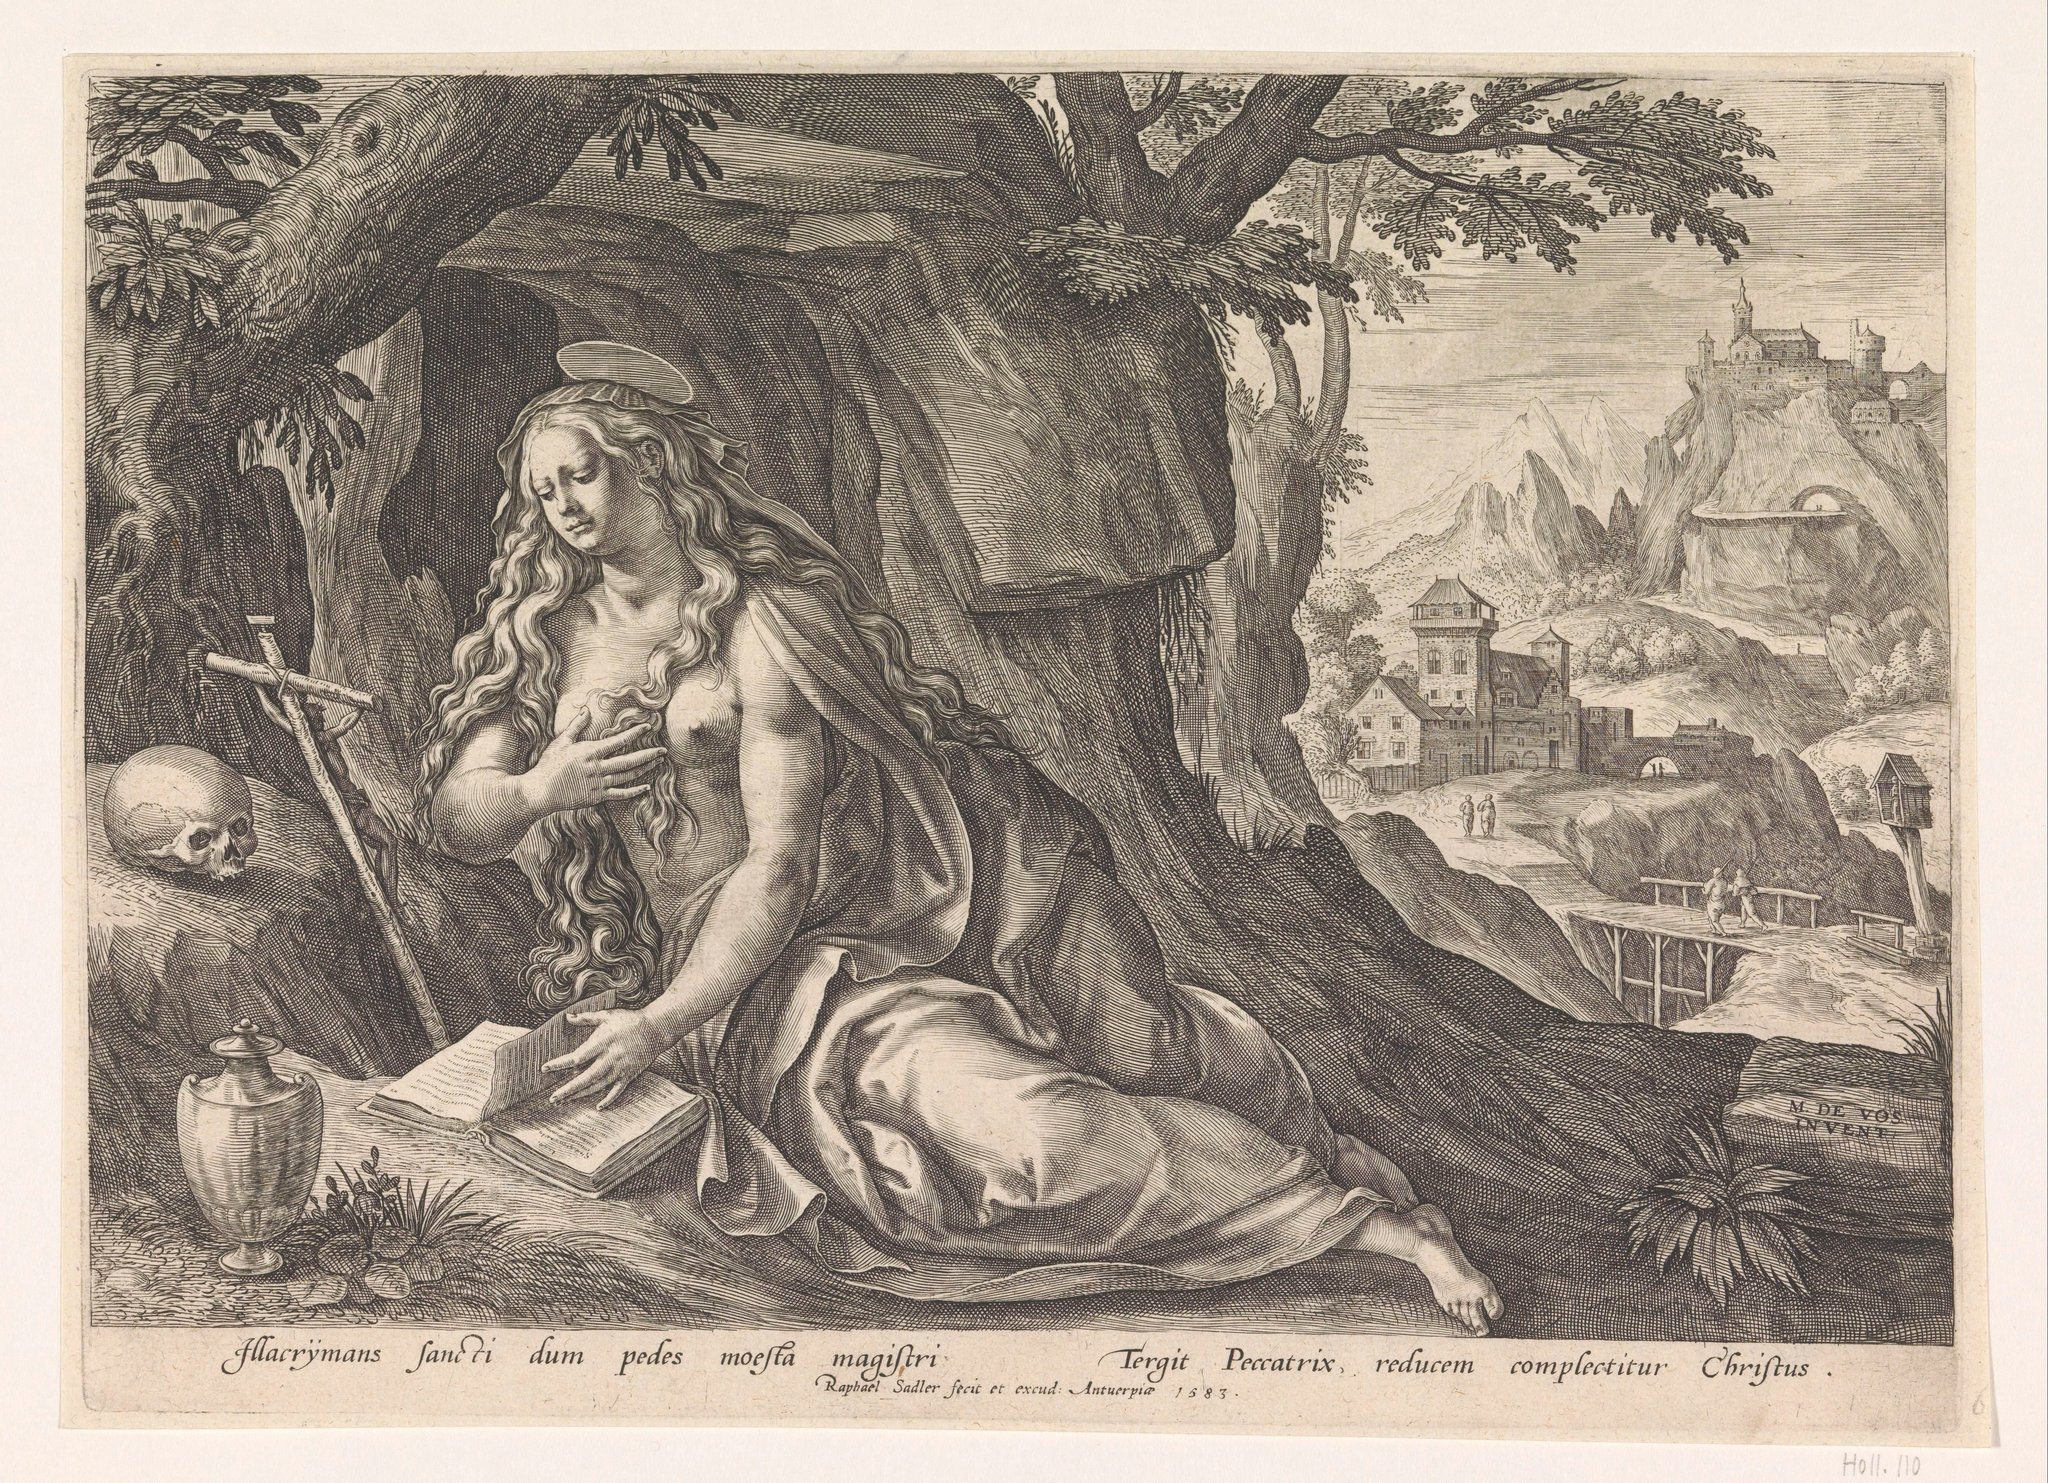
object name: print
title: Maria Magdalena in de wildernis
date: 1583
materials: paper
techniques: engraving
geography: antwerp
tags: mountains, the penitent harlot mary magdalene; possible attributes: book (or scroll), crown, crown of thorns, crucifix, jar of ointment, mirror, musical instrument, palm-branch, rosary, scourge - apotheosis, glory, triumph of female saint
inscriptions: collector's mark: Lugt 2228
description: Maria Magdalena in de wildernis. Ze leest een bijbel voor de grot waarin ze woont. Een bergachtig landschap op de achtergrond.